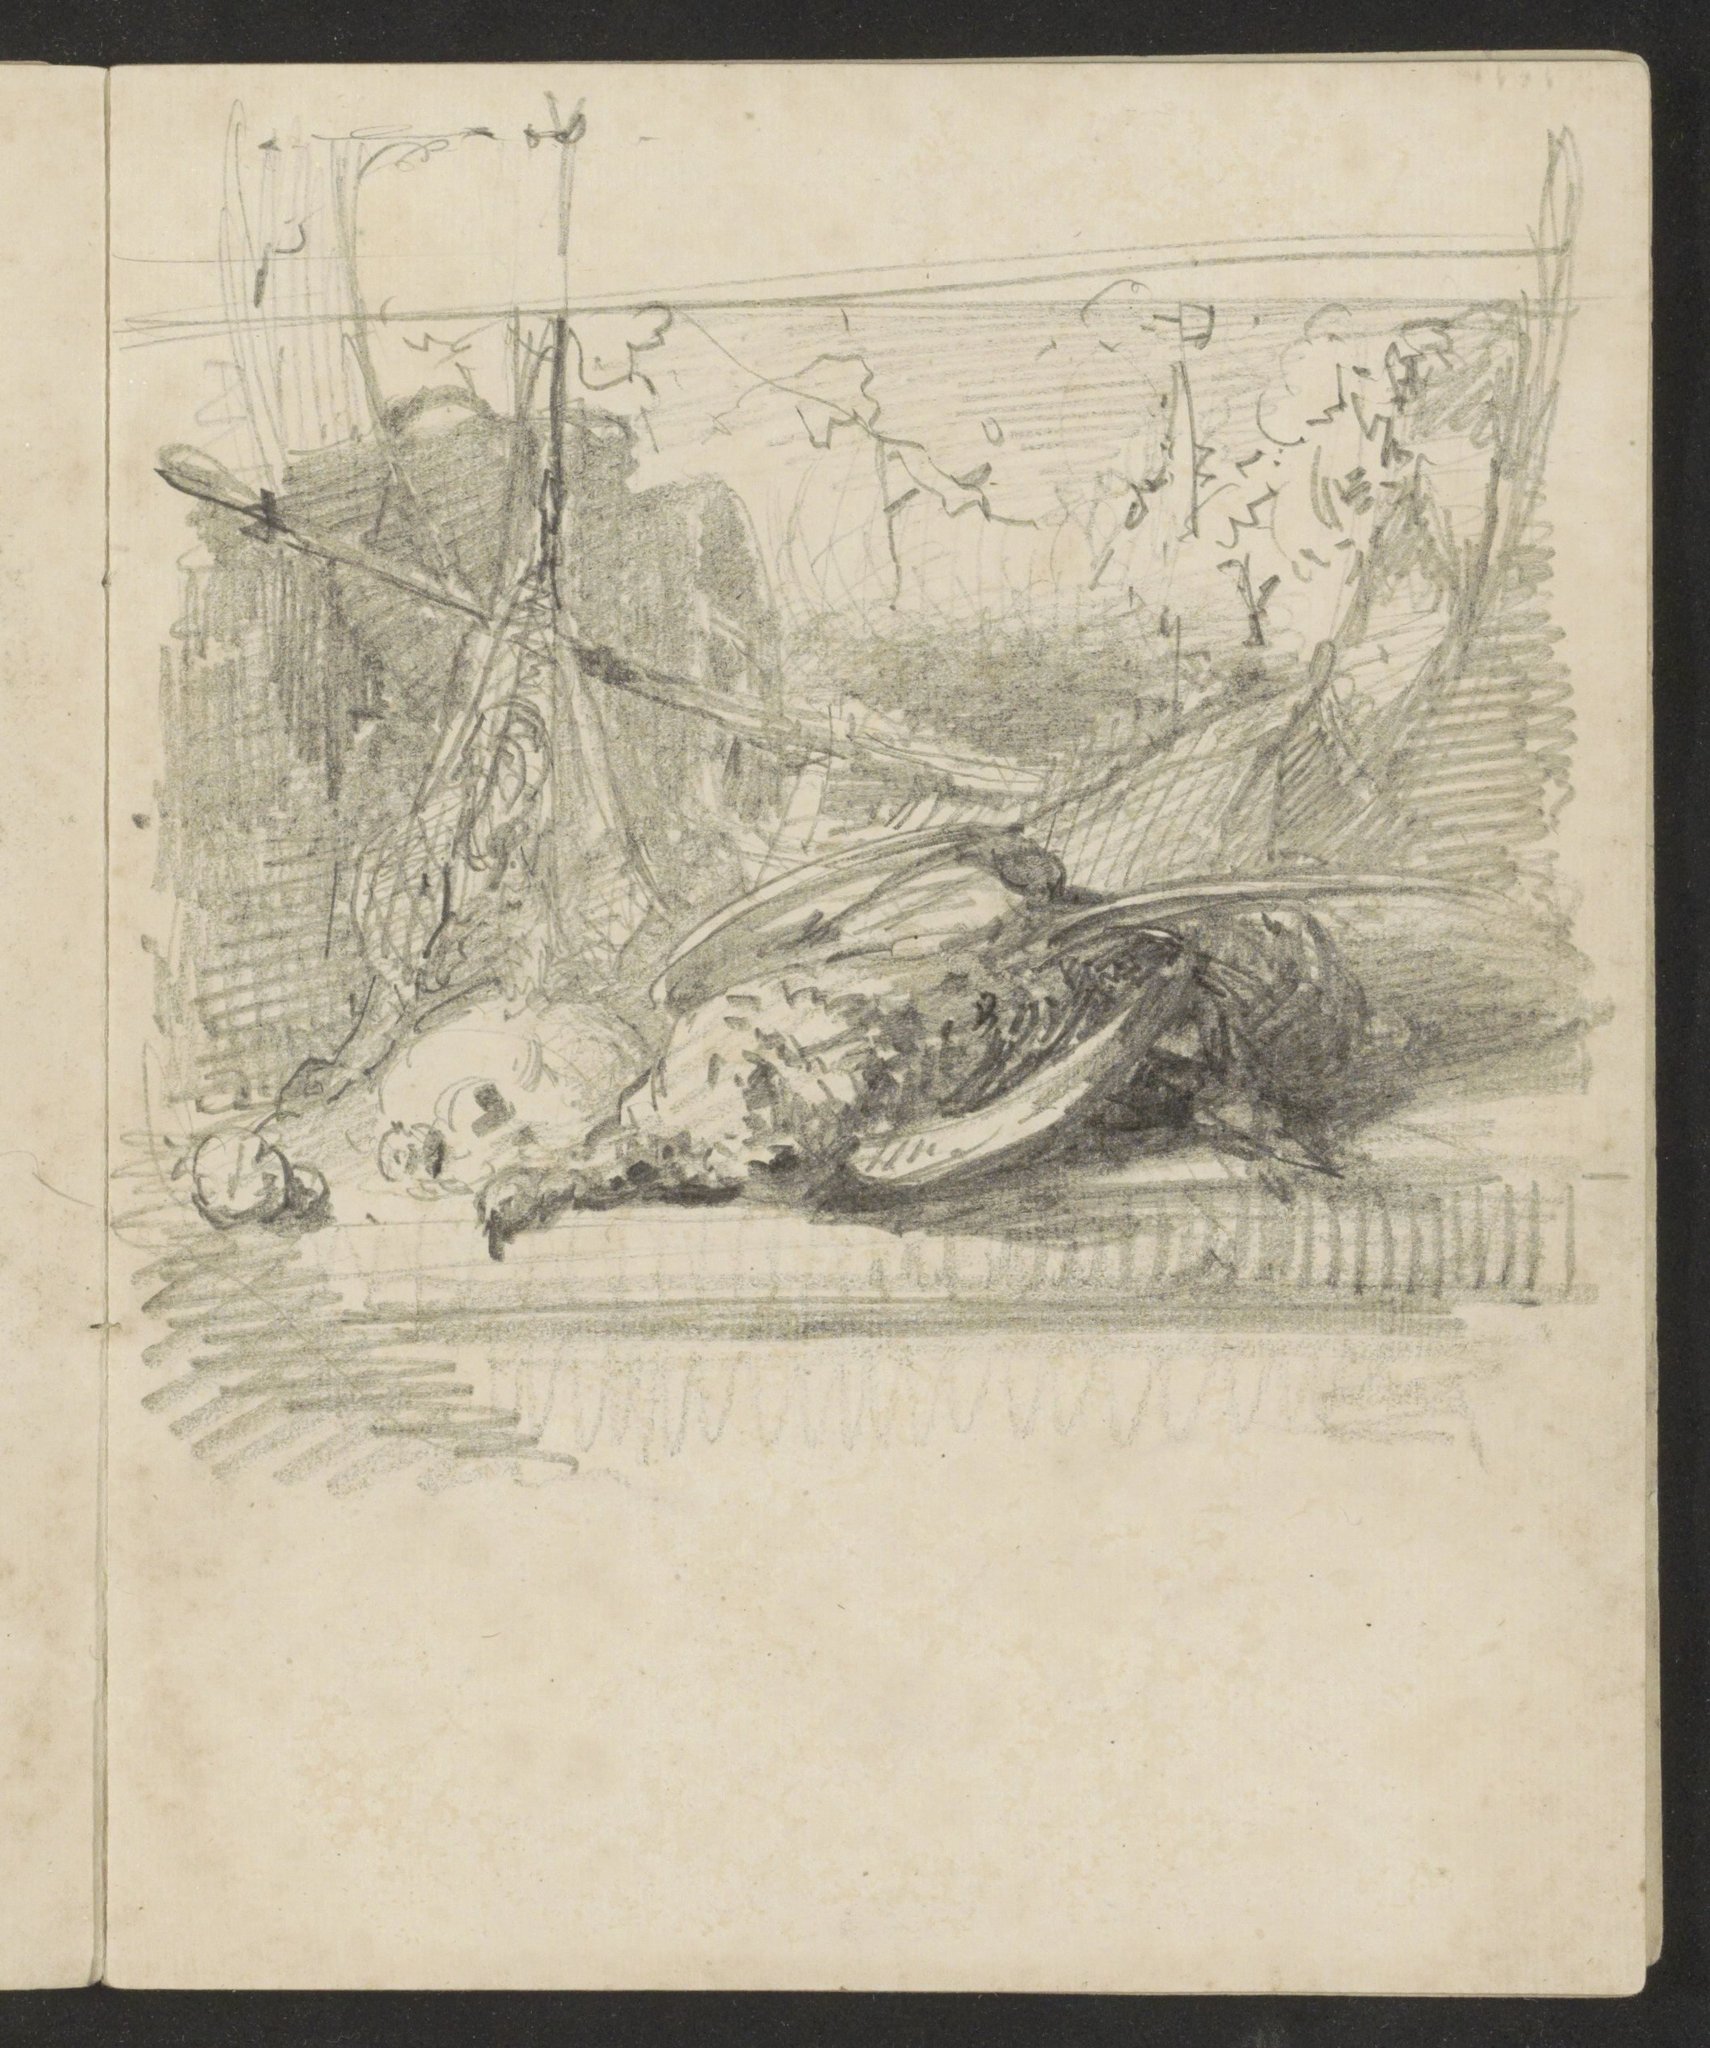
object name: sketchbook leaf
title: Stilleven met dood gevogelte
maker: maria vos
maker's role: draughtsman, painter, print maker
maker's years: 1824-1906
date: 1834-1906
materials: paper, pencil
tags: still life of related objects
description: Op de achtergrond de suggestie van een landschap. Blad 8 recto uit een schetsboek met 21 bladen.